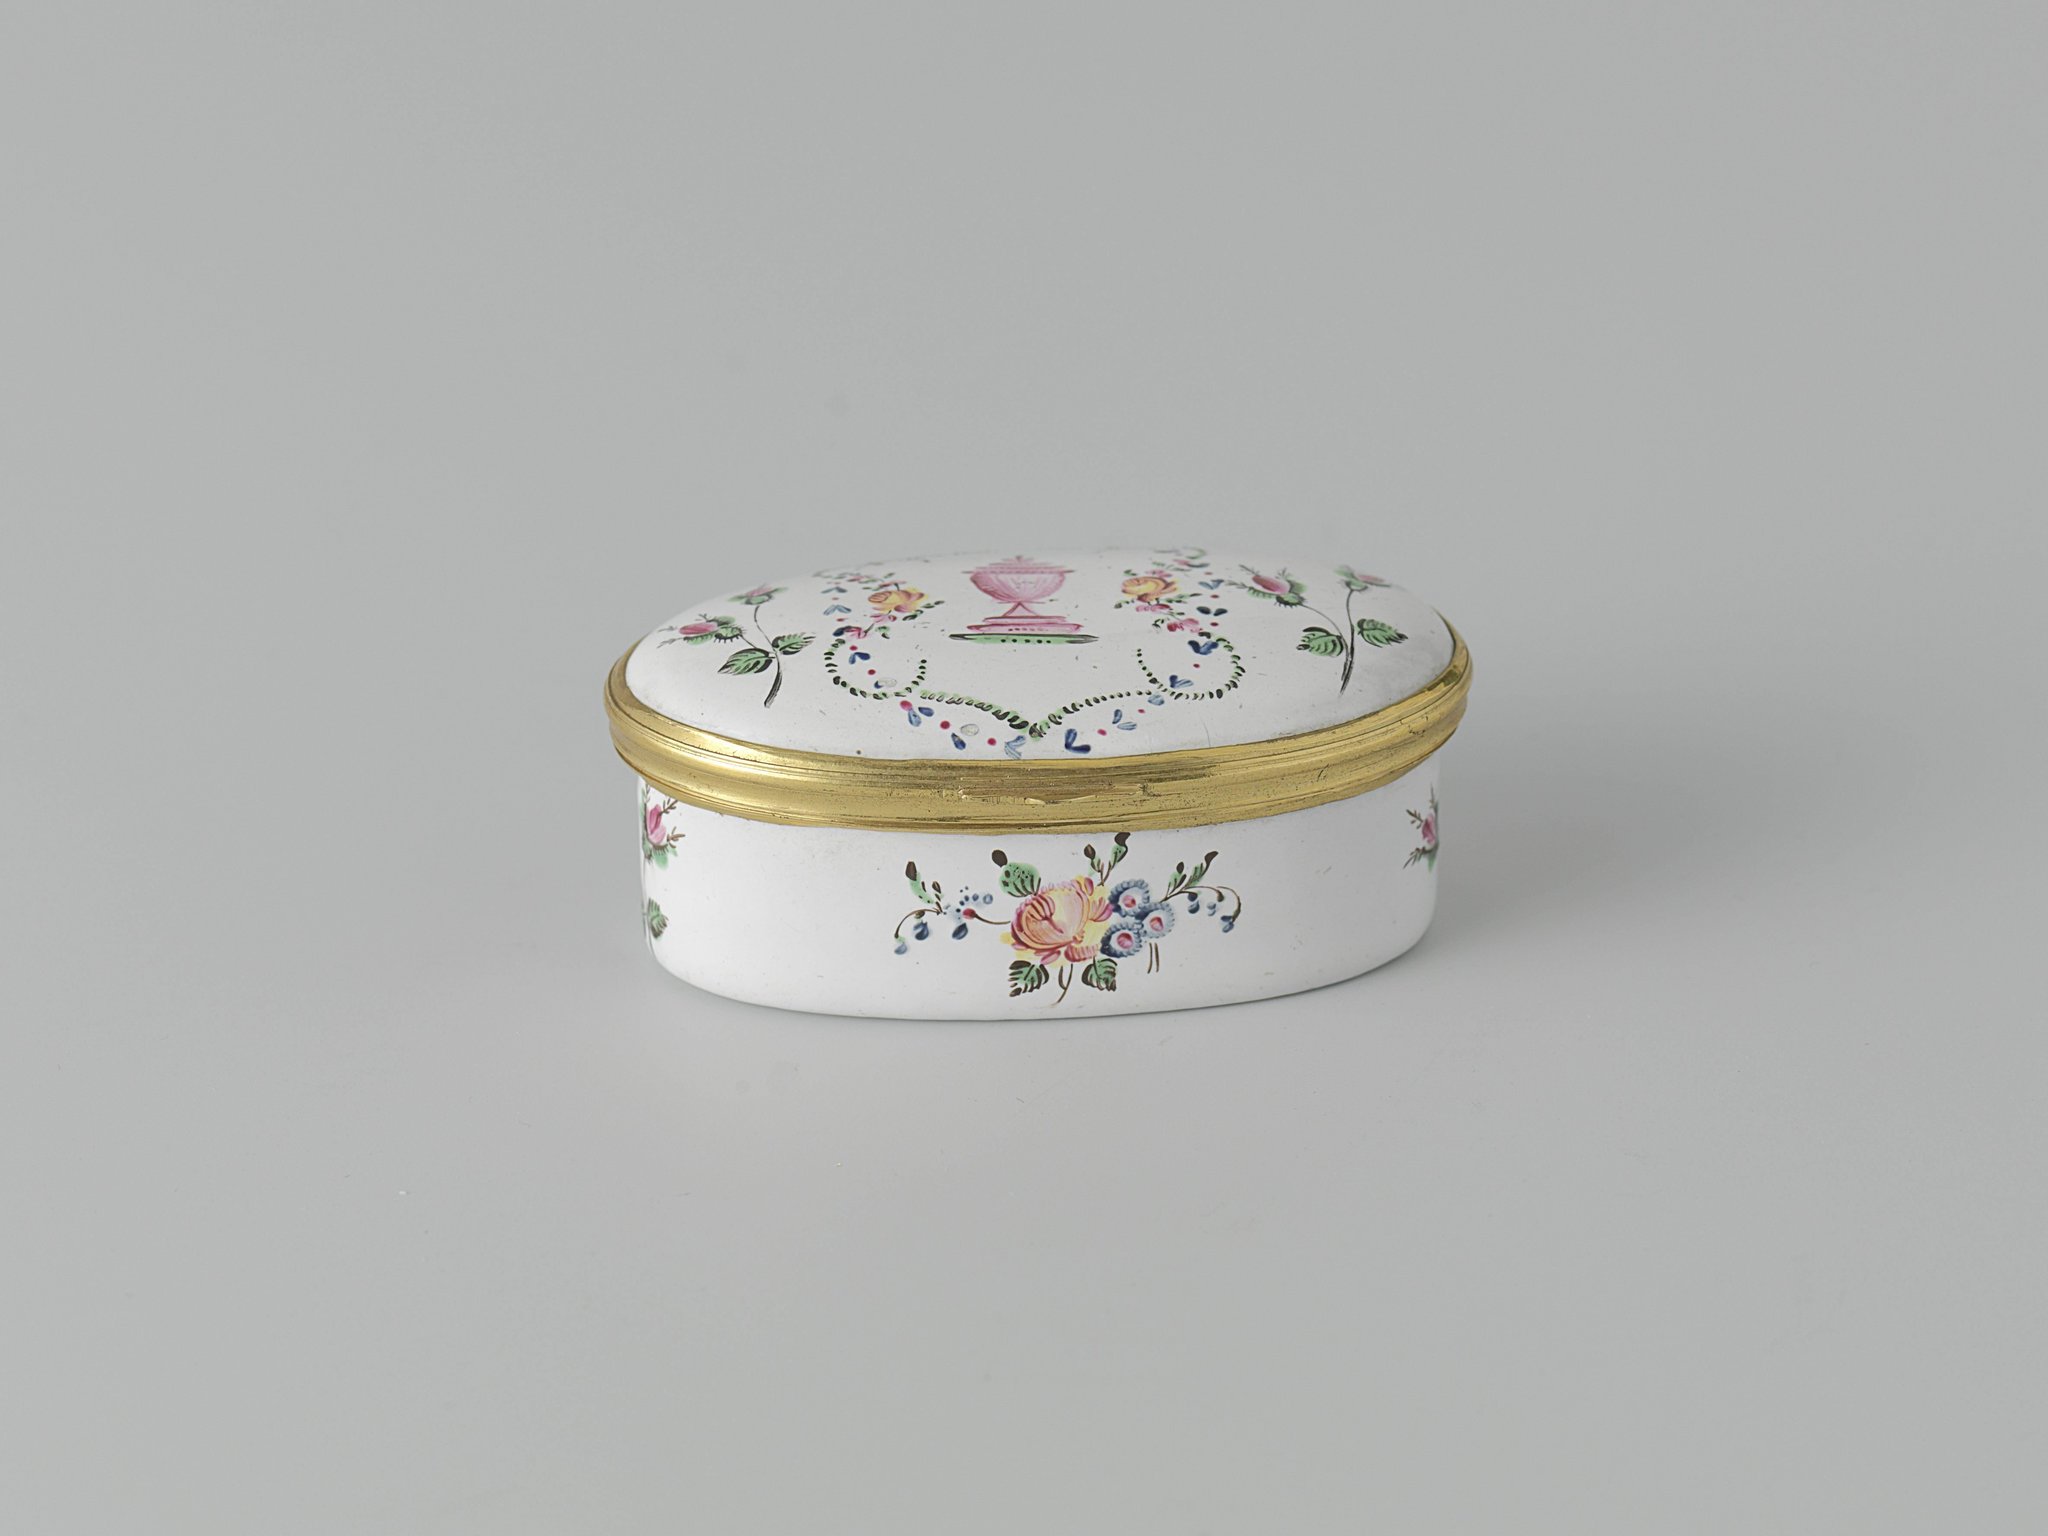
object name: snuffbox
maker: Anonymous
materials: enamel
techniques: enamel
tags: flowers: rose, garden vase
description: Snuifdoos, ovaal, van Battersea émail, met op de gewelfde deksel een versiering van een vaasmotief tussen twee rozenknoppen.